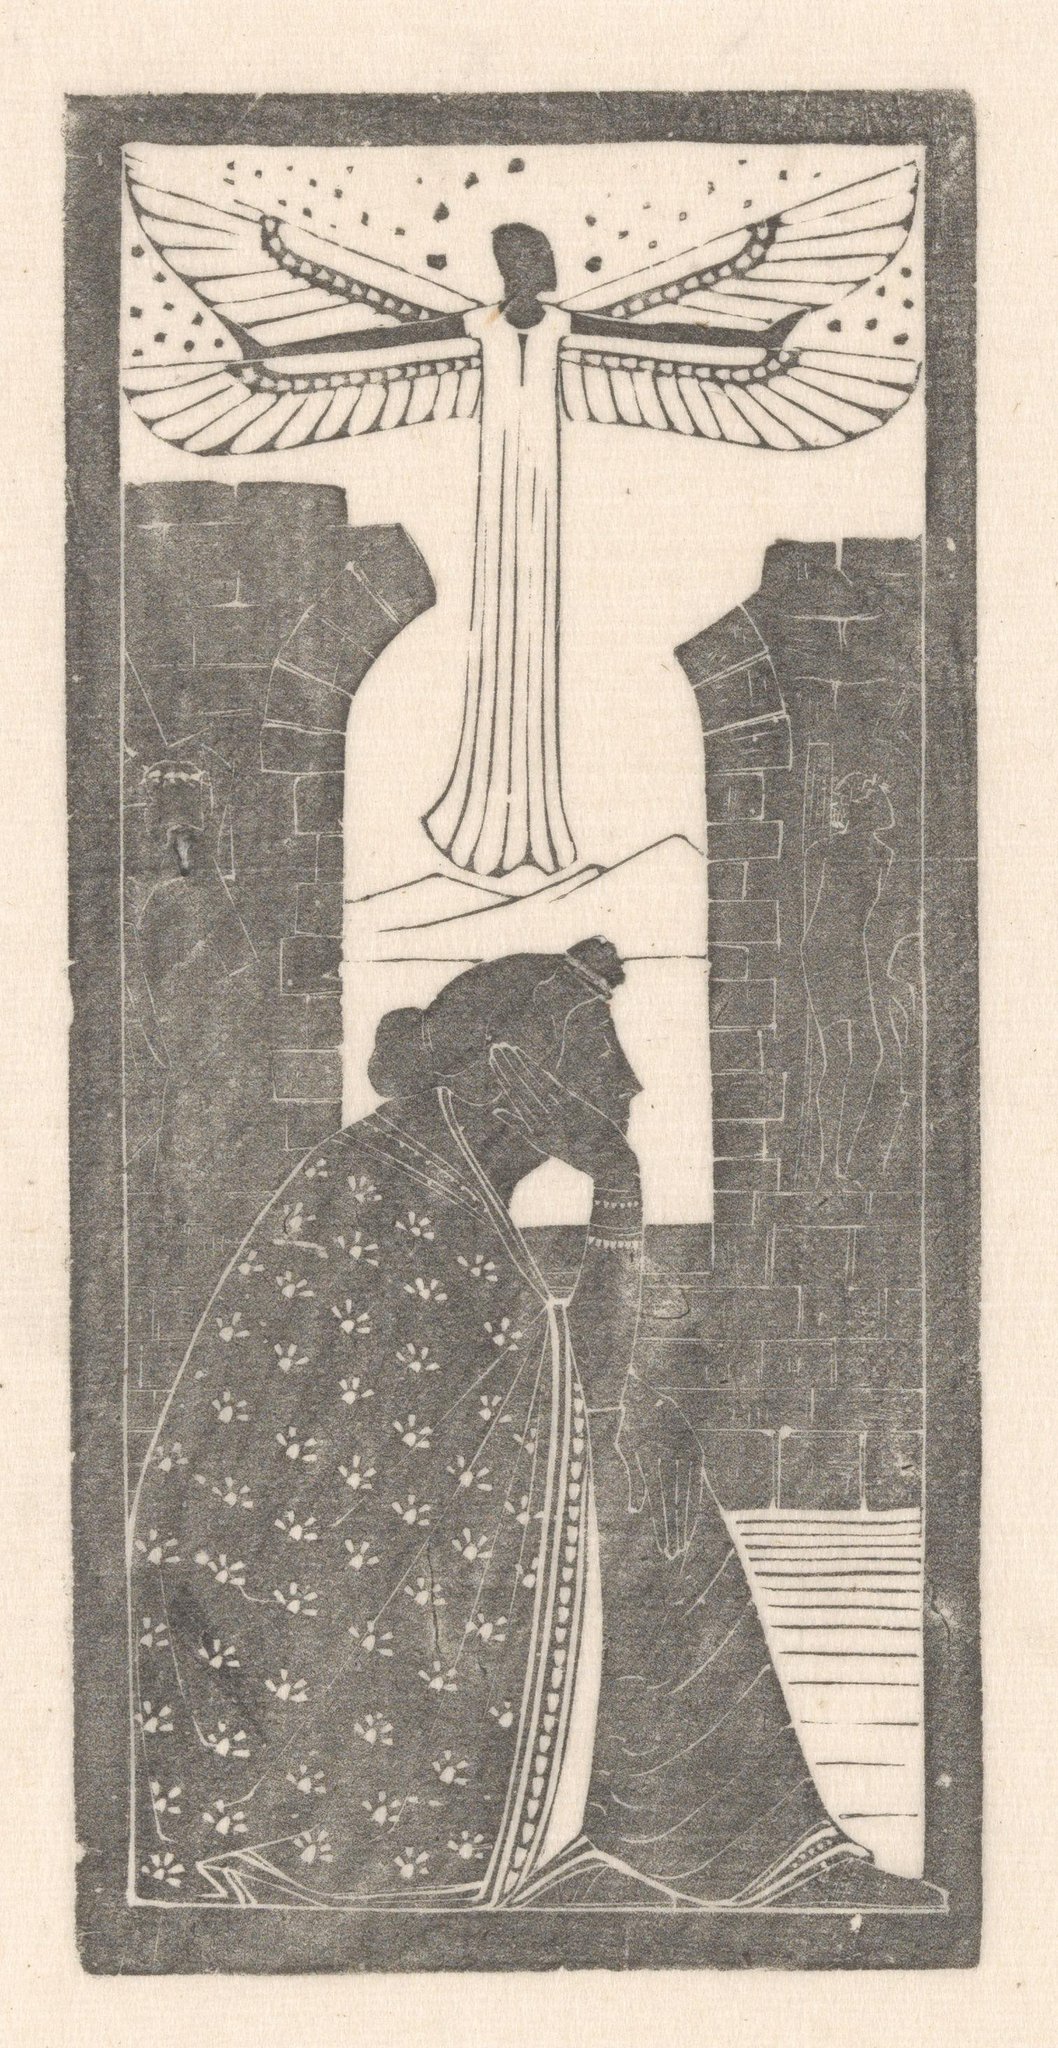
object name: print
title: Figuur met vier vleugels bij ruïne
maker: karel petrus cornelis de bazel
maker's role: draughtsman, print maker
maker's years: 1869-1923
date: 1894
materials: paper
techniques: woodcut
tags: ruin of a building ~ architecture, fabulous beings with wings, sitting on the ground - aa - female human figure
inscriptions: collector's mark: Lugt 2228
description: Een figuur met vier vleugels zweeft in de lucht. Op de voorgrond een zittende vrouw die haar rechterhand tegen haar wang houdt en haar linkerarm op haar schoot laat rusten. Op de achtergrond een ruïne van een gebouw. Door een venster is zicht op een berglandschap.